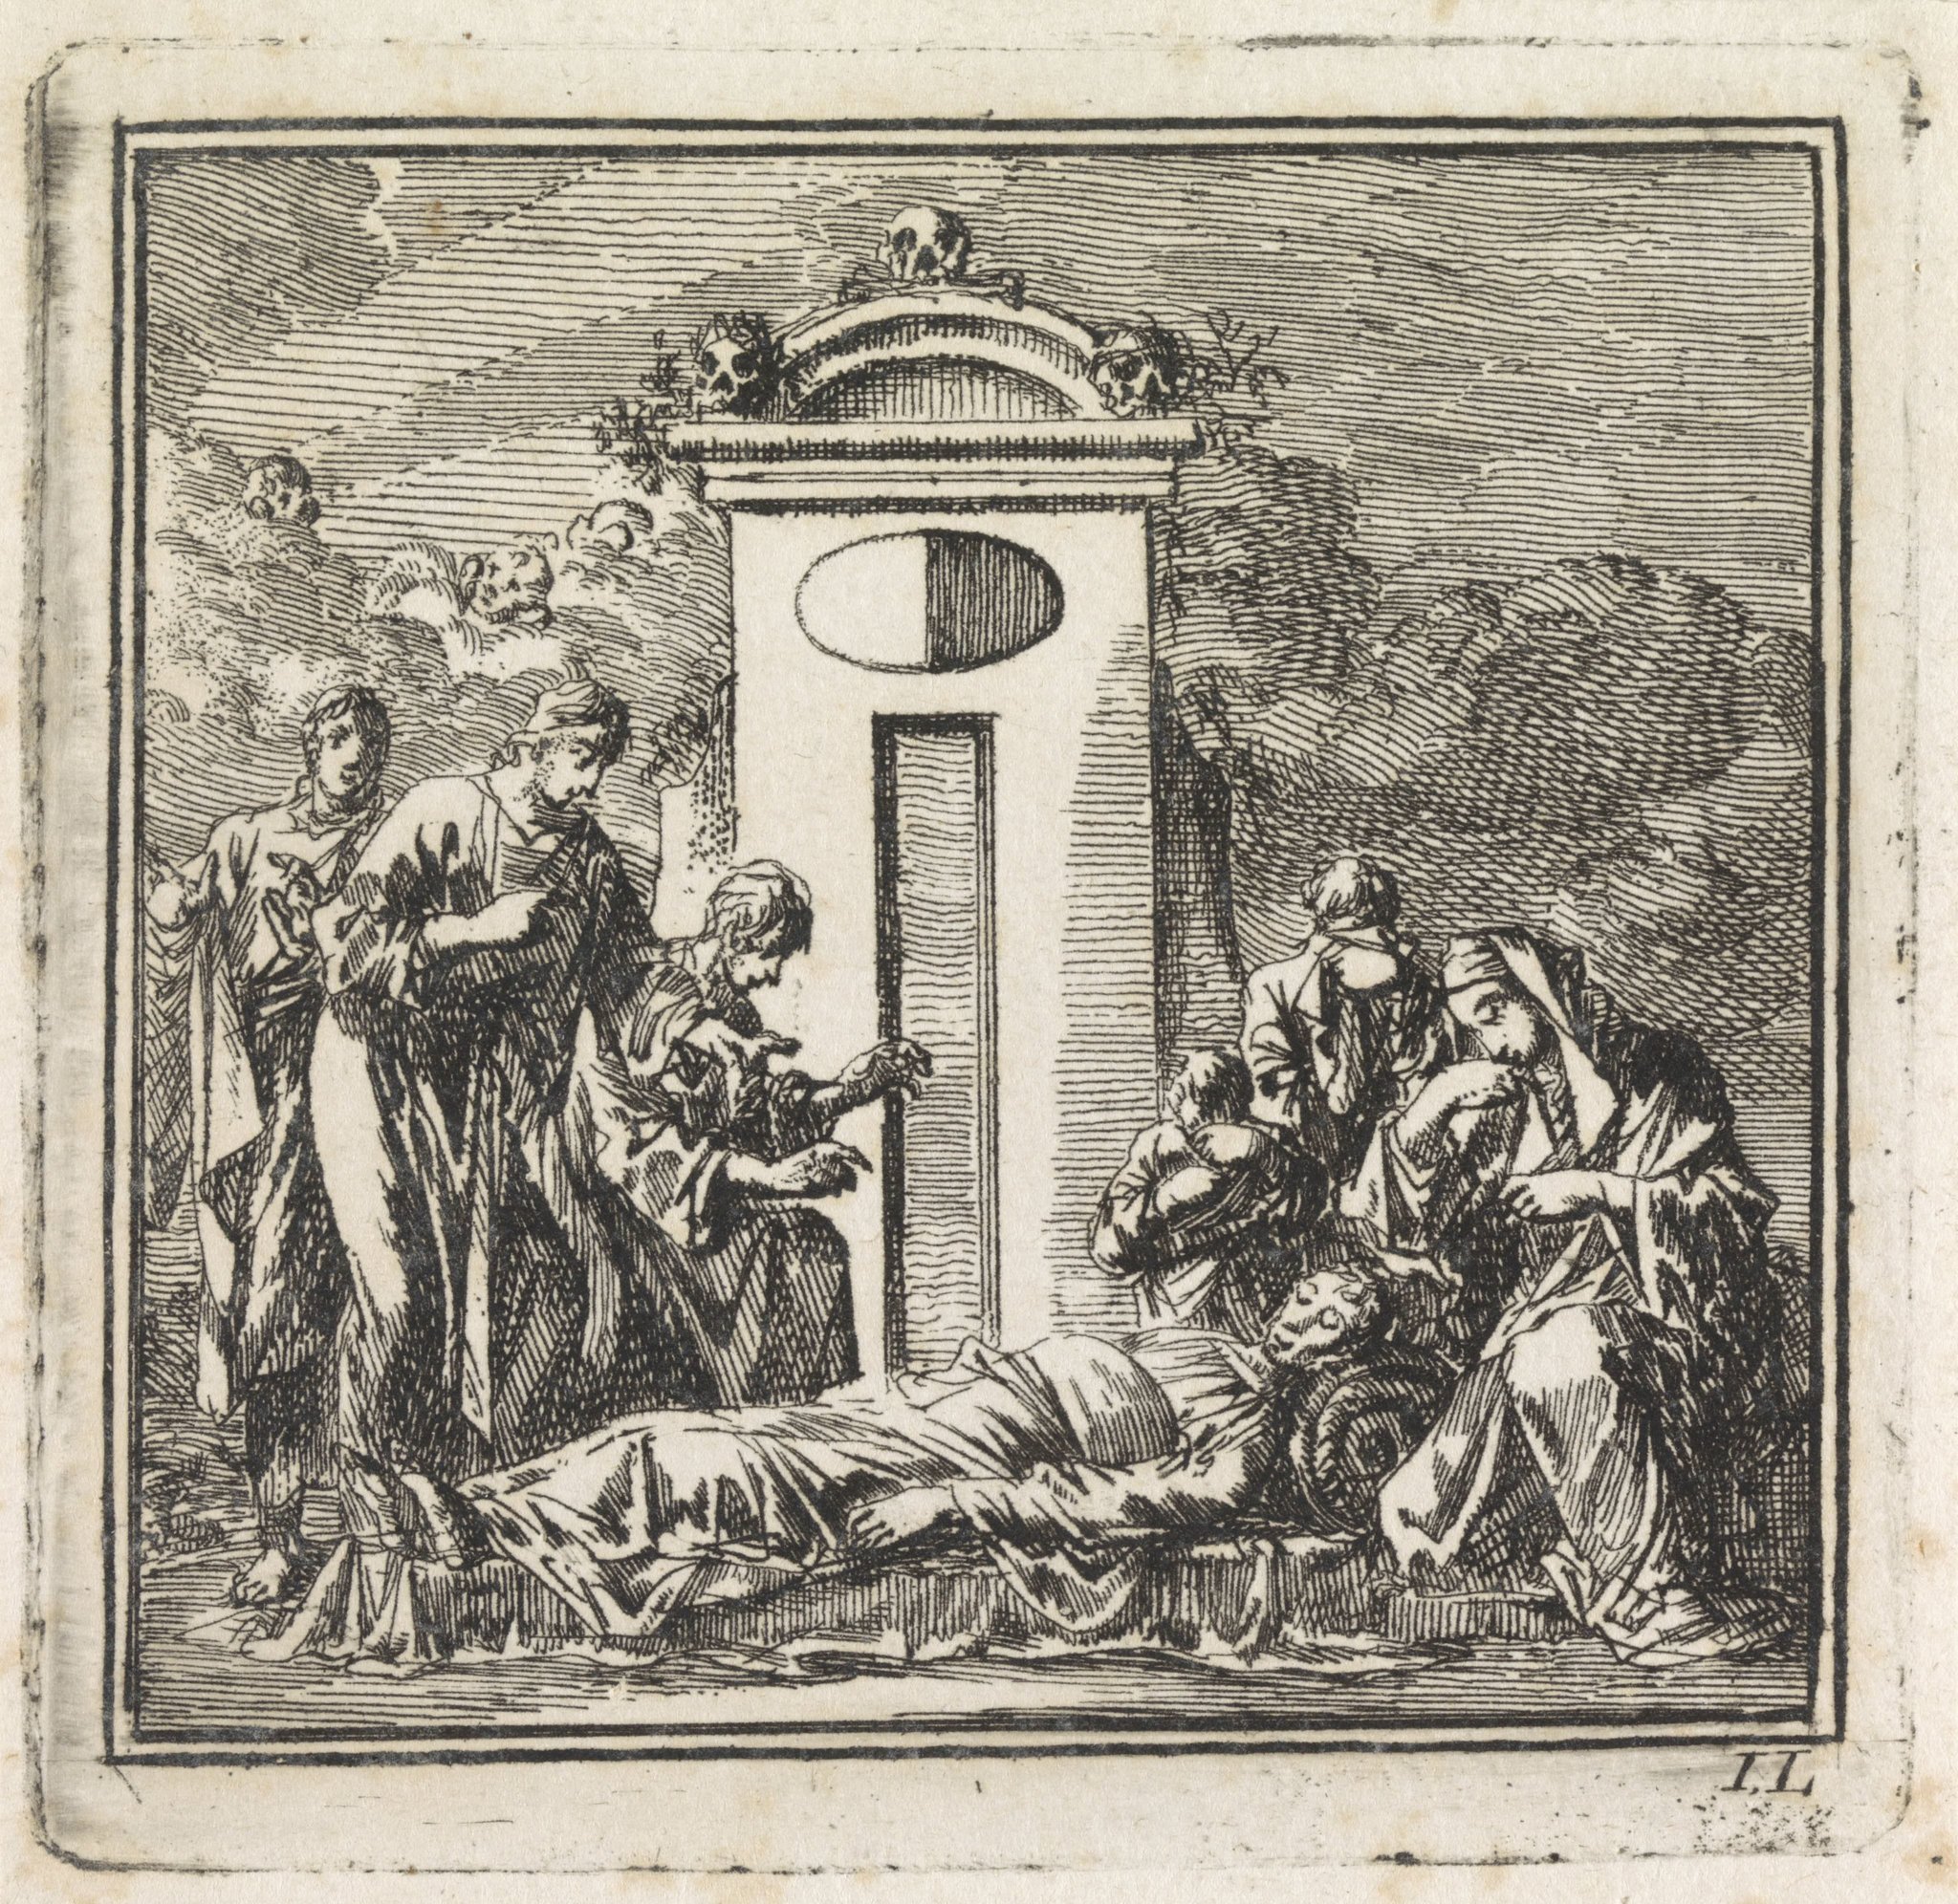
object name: print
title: Het Lyk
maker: jan luyken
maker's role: draughtsman, print maker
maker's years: 1649-1712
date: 1710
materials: paper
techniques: etching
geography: amsterdam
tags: mourning the dead, angels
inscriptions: collector's mark: Lugt 2228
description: Illustratie uit: Luyken, Jan. De onwaardige wereld, vertoond in vyftig zinnebeelden, met godlyke spreuken en stichtelyke verzen. Amsterdam: Pieter Arentsz. II (wed.) en Cornelis van der Sys, 1710, p. 90.